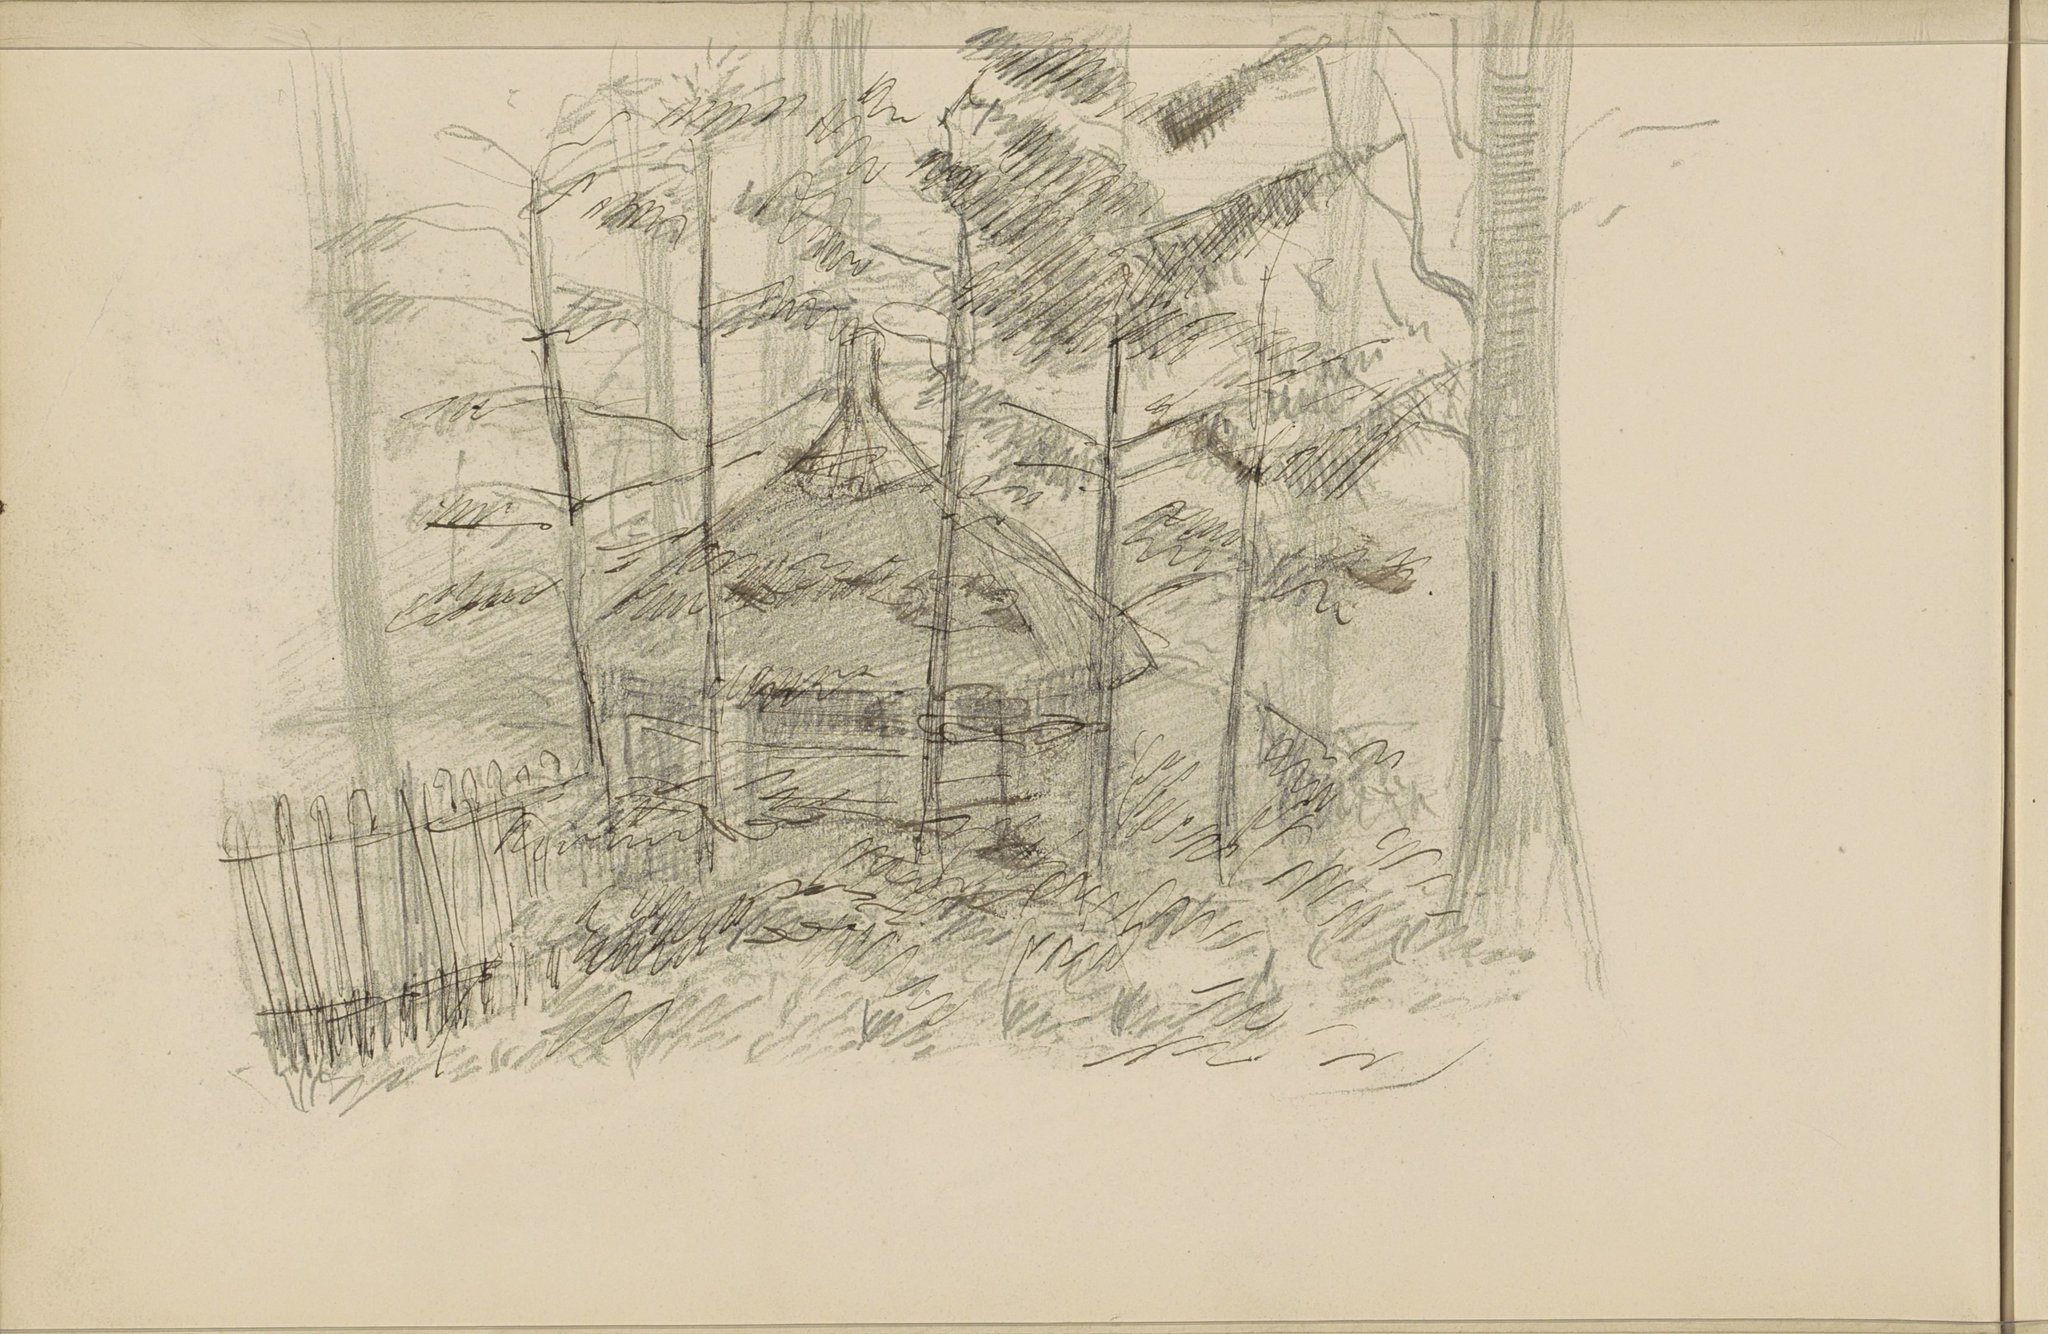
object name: sketchbook leaf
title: Hut in het bos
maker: jozef israëls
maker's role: draughtsman, painter, print maker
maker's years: 1824-1911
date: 1834-1911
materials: ink, paper, pencil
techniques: pen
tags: forest, wood, hut, cabin, lodge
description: Blad 12 verso uit een schetsboek met 25 bladen.